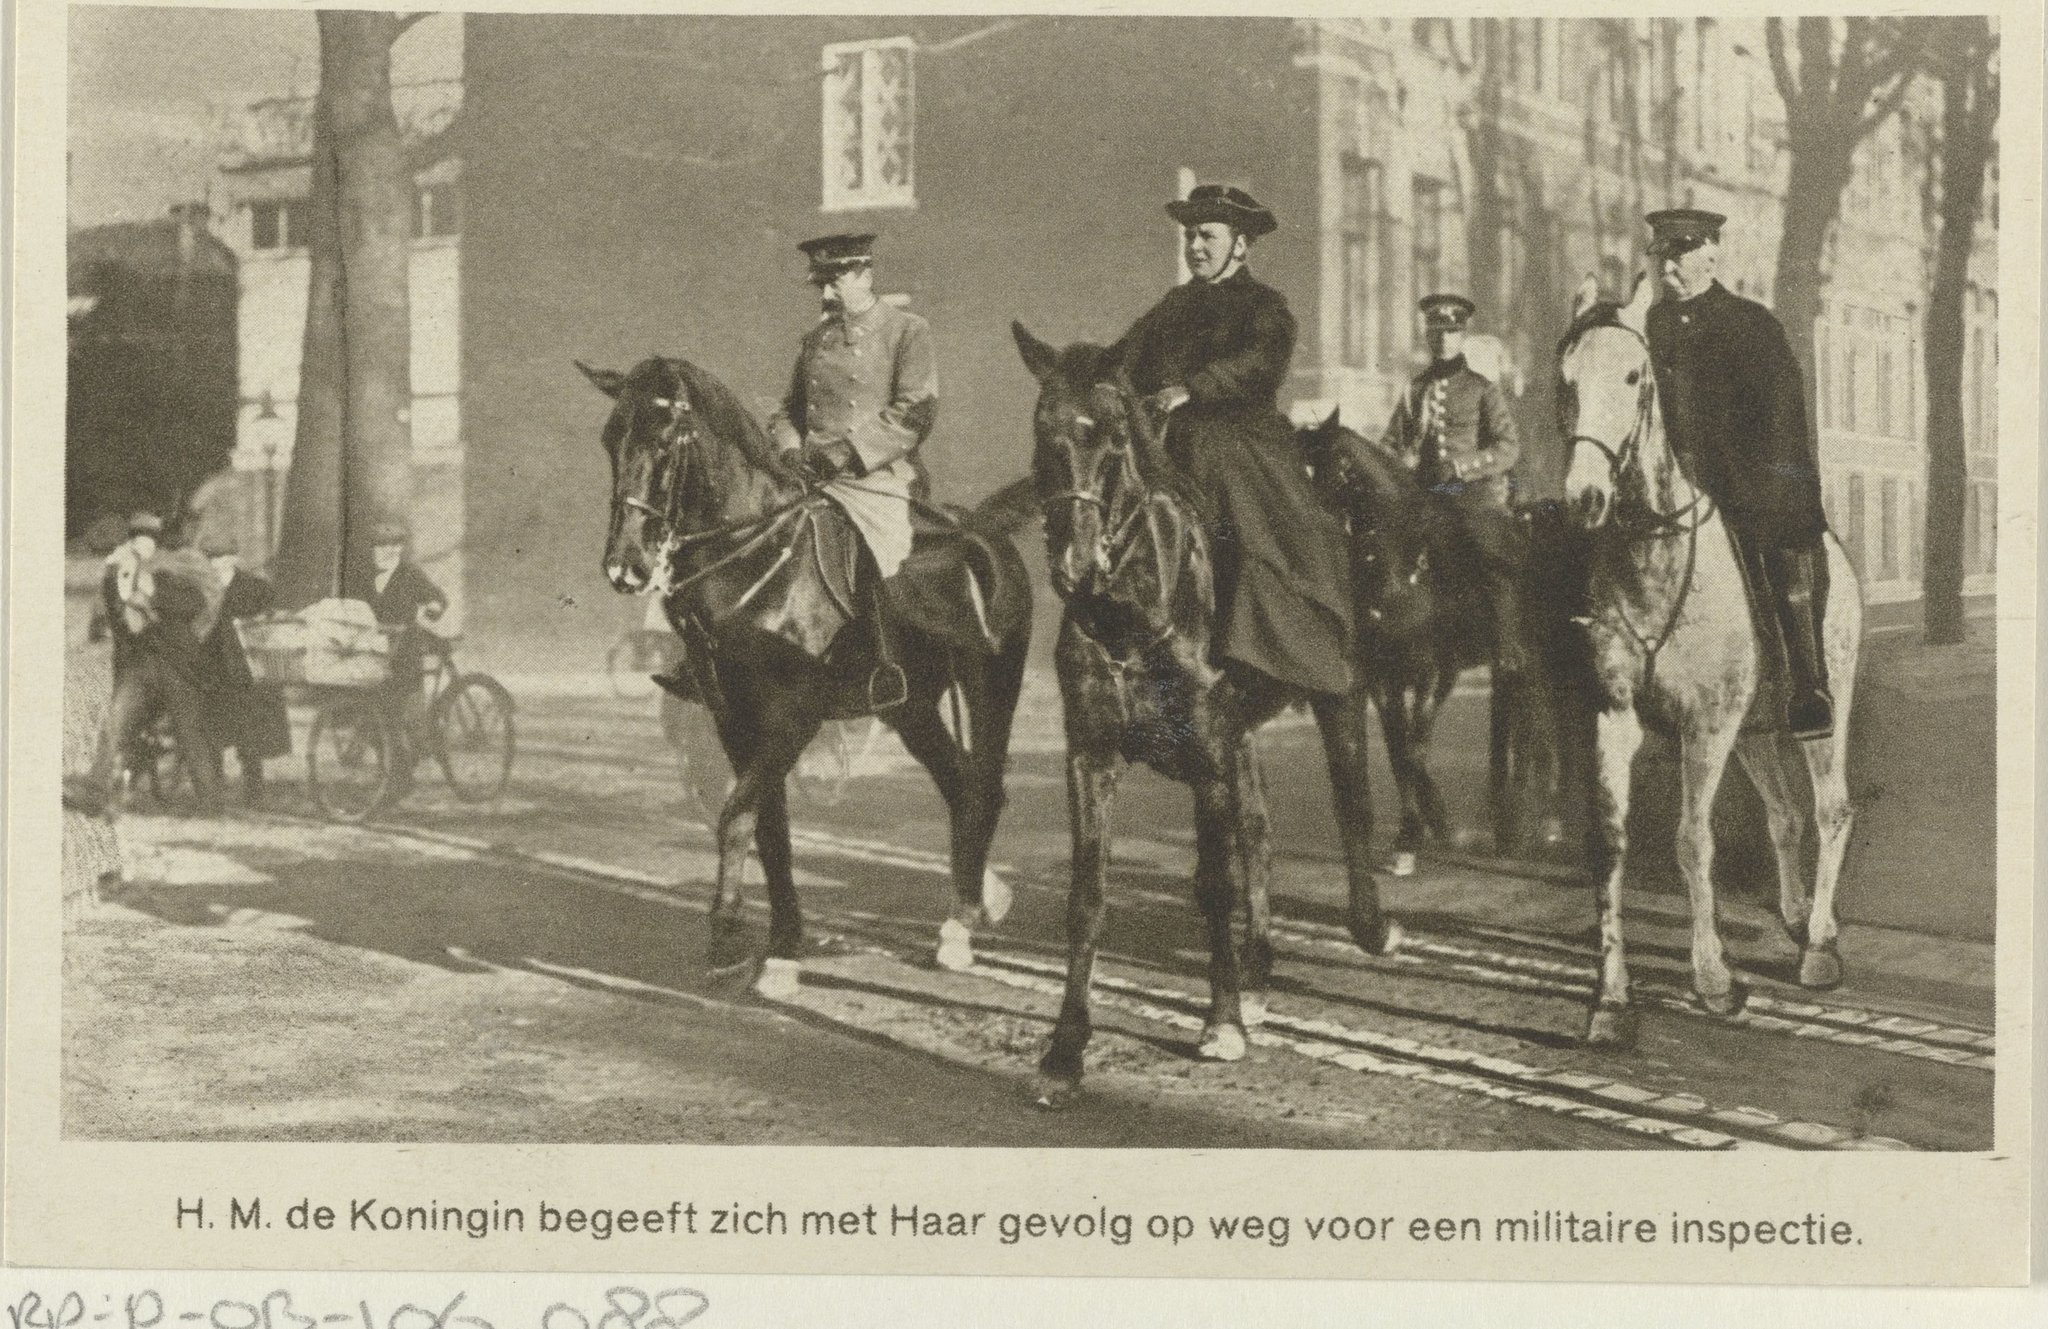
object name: ansichtkaart, prentbriefkaart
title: Wilhelmina, koningin der Nederlanden, begeeft zich met haar gevolg op weg voor een militaire inspectie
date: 1914-1940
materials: paper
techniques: rotogravure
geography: the hague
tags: the hague, print maker, wilhelmina of the netherlands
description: De hier vermelde titel verwijst naar de hoogst verkregen titel van de geportretteerde, niet per se naar de titel die de geportretteerde op deze voorstelling draagt.